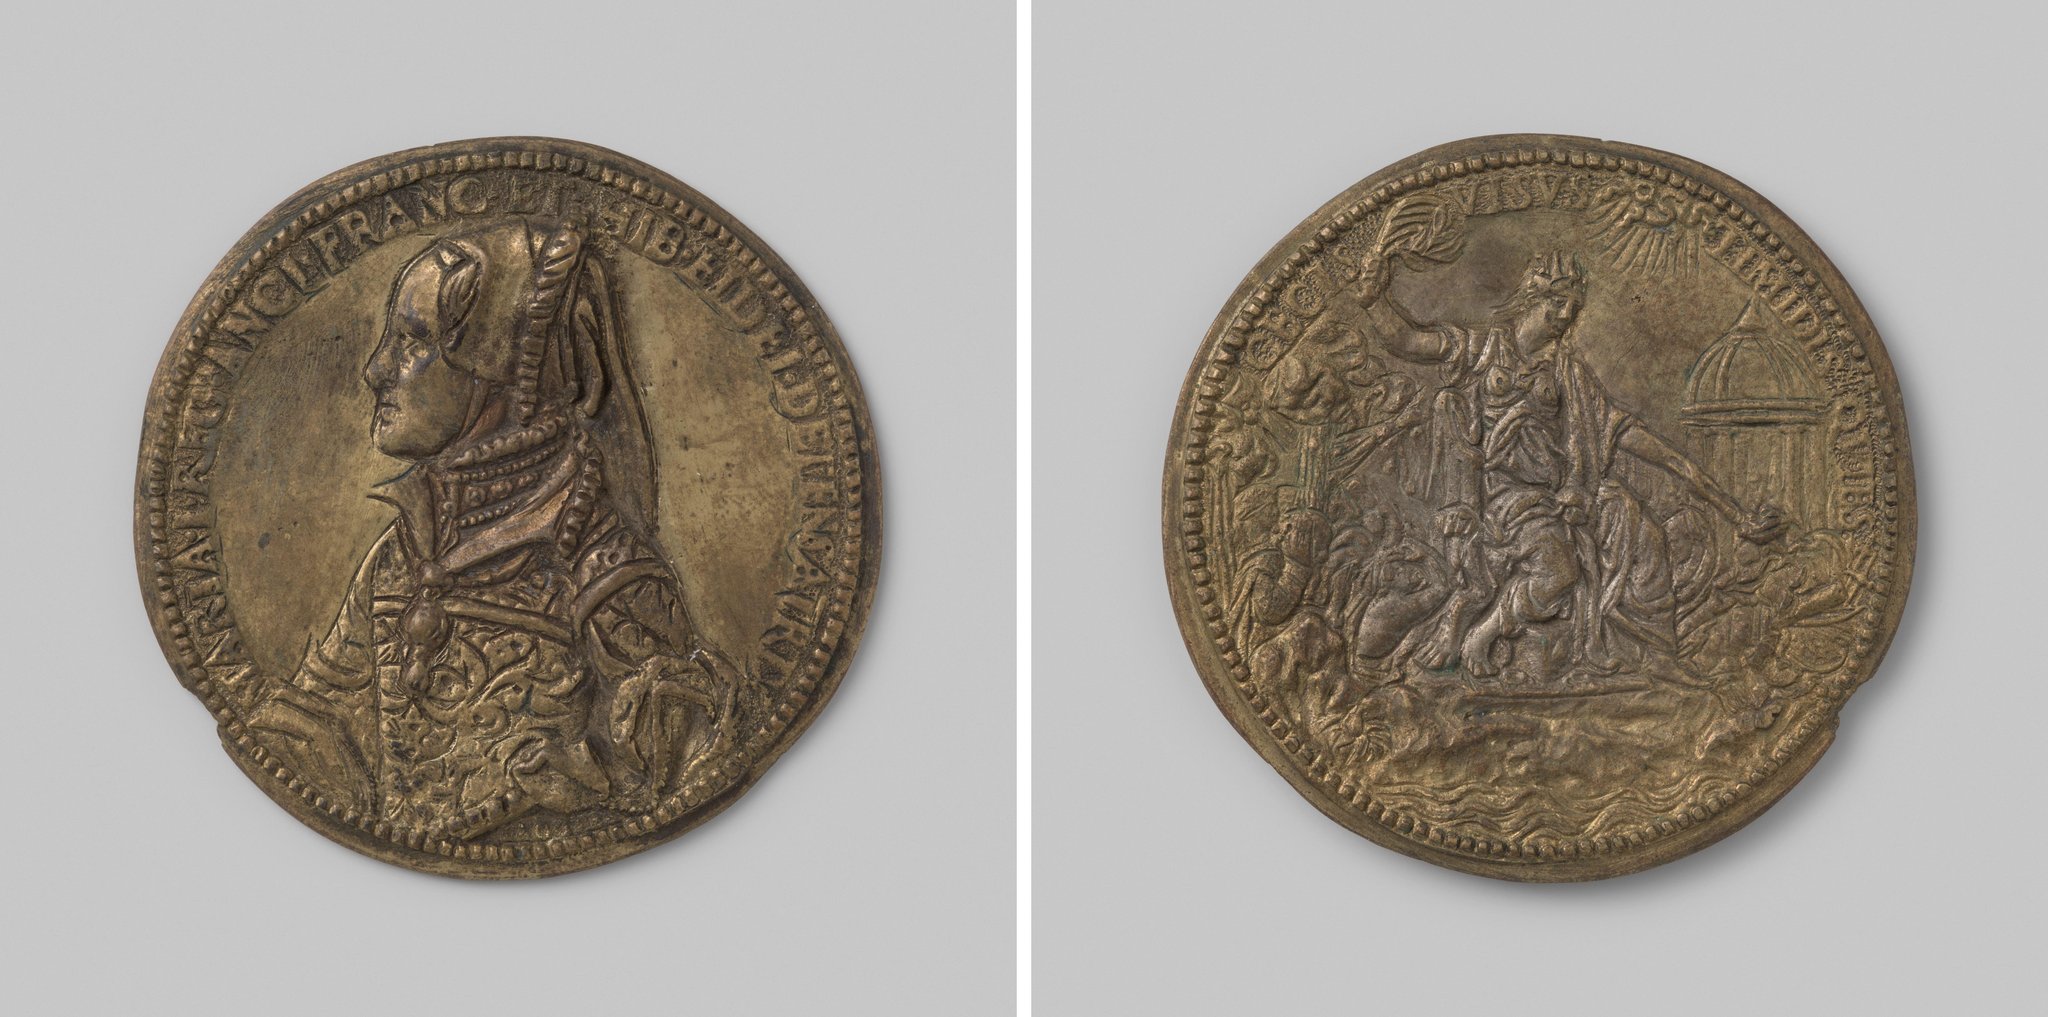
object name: copy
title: Maria I van Engeland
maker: jacopo nizzola da trezzo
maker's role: medailleur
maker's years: 1515-1589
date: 1555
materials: bronze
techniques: casting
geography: brussels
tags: london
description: Bronzen penning. Voorzijde: borststuk vrouw binnen omschrift. Keerzijde: beschenen door hemellicht steekt Maria, afgebeeld als Vrede zittend op steen, met toorts naast haar liggende stapel wapentuig in brand en houdt zij met andere hand palm- en olijftakken boven groep smekelingen, die geteisterd wordt door storm en water; aan haar voeten ligt weegschaal, op achtergrond rechts een tempel binnen omschrift.